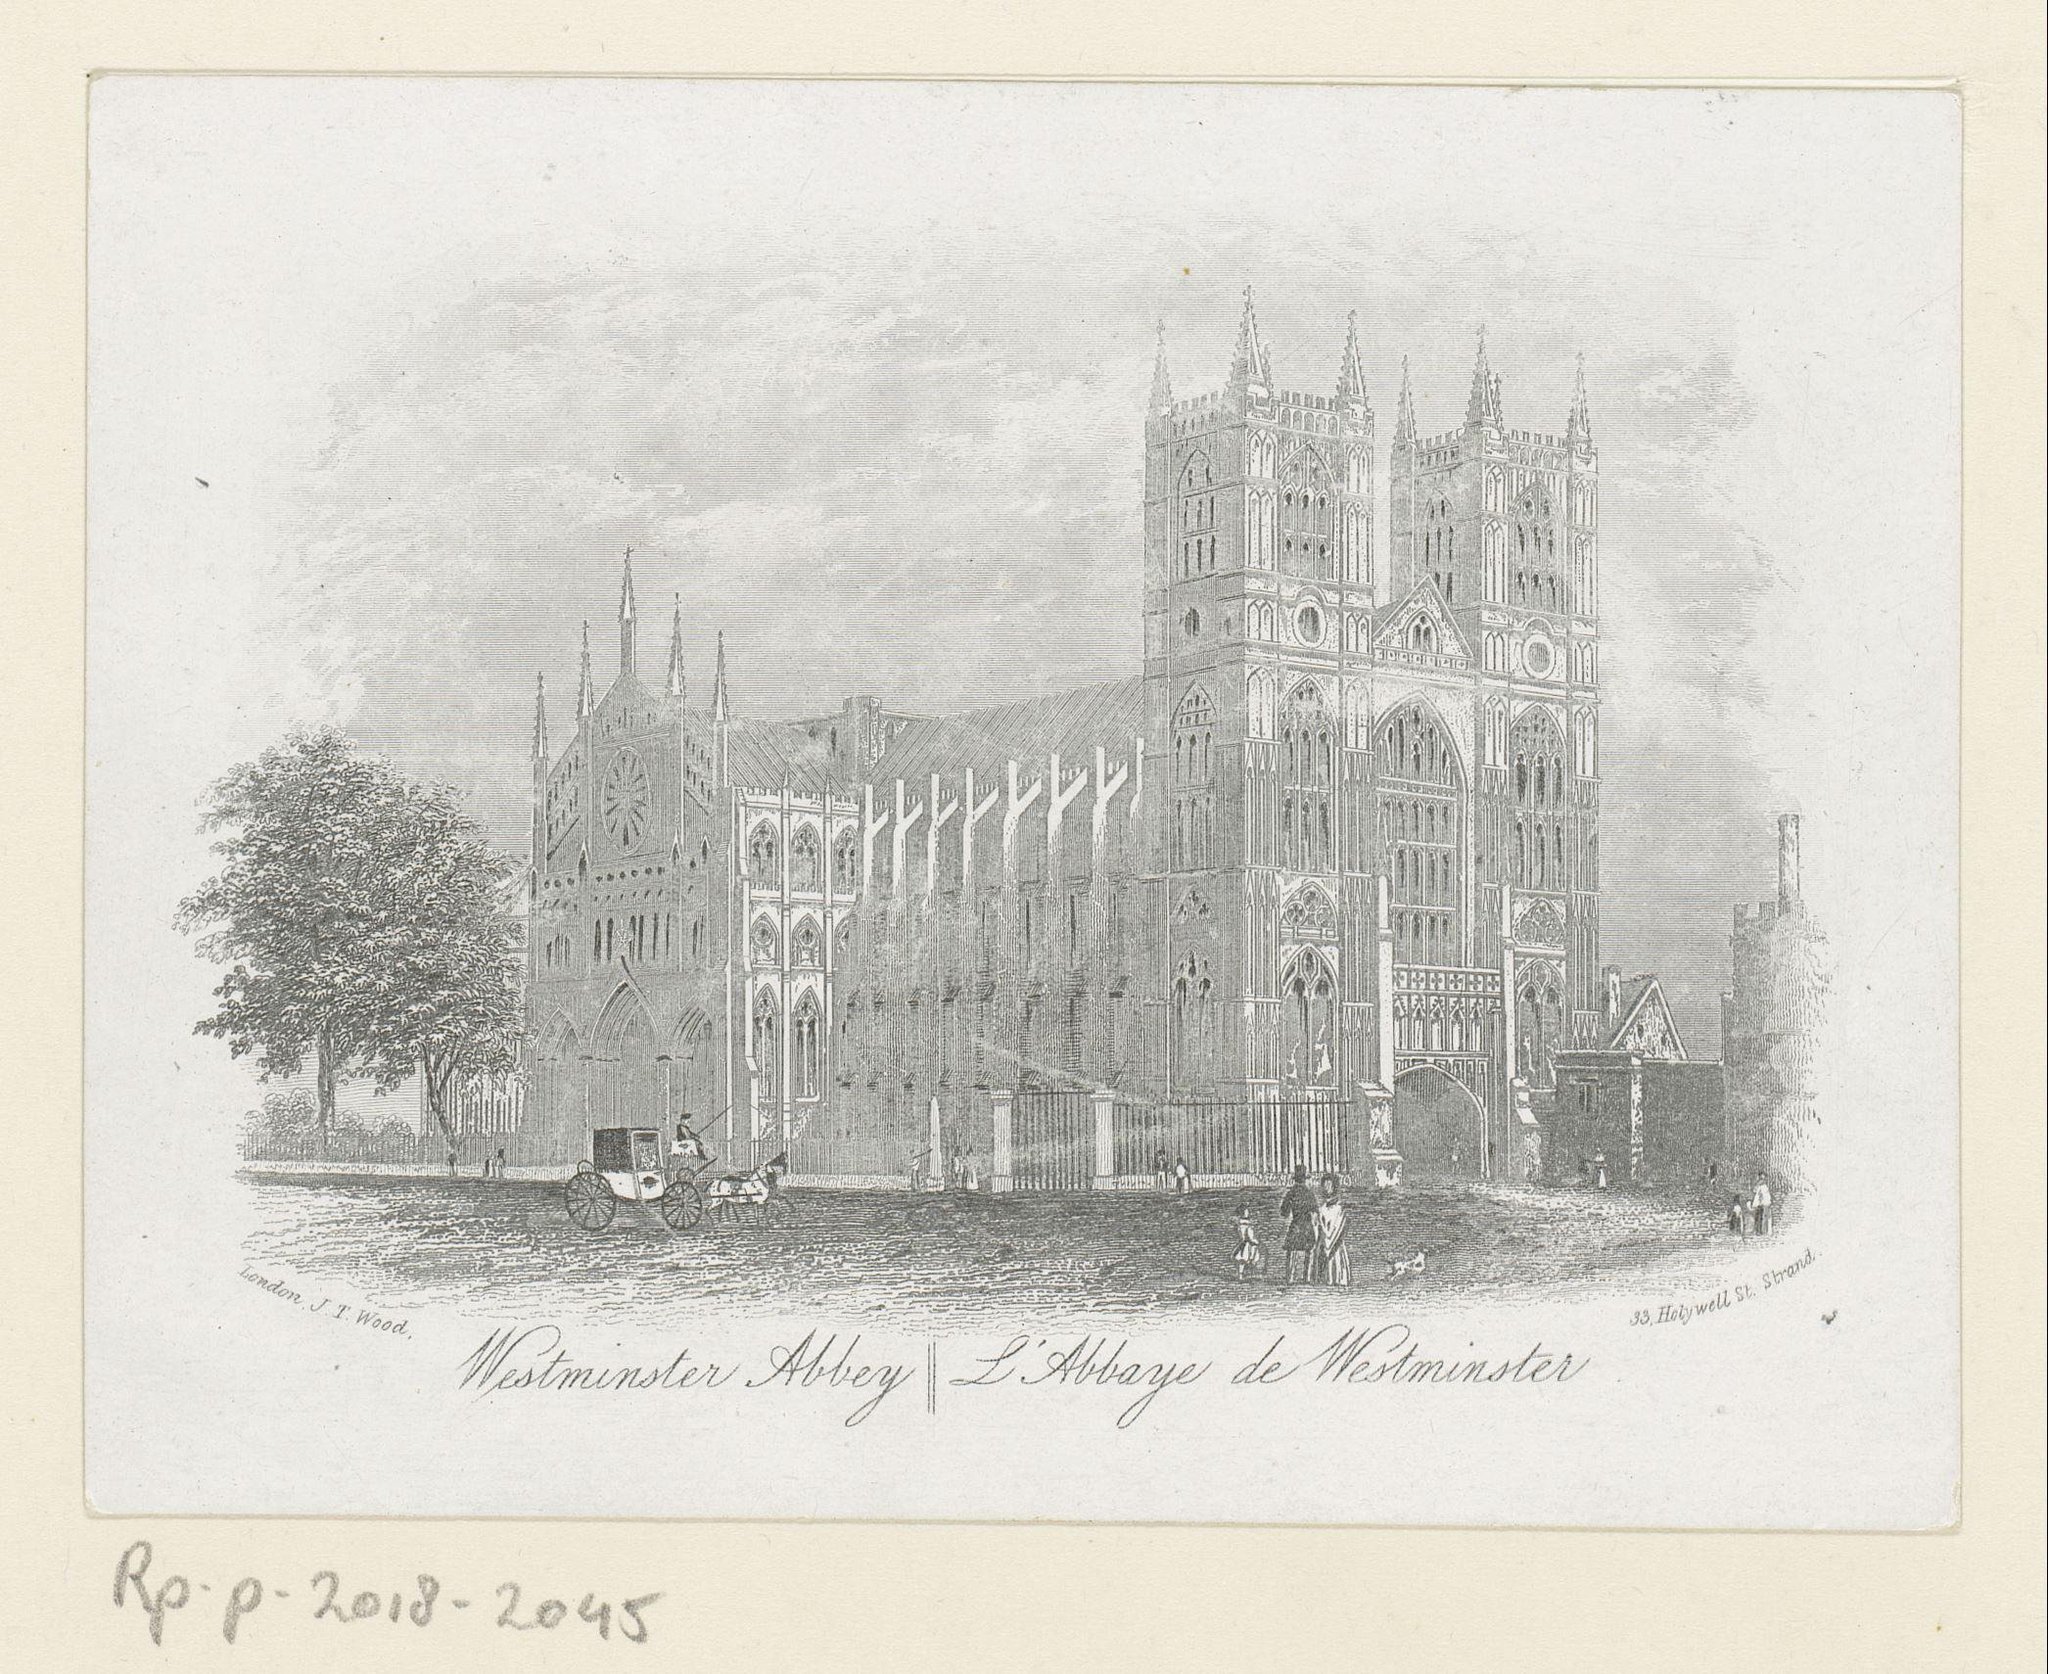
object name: print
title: Gezicht op Westminster Abbey, te Londen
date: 1841-1885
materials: paper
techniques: etching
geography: london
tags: church (exterior), westminster abbey